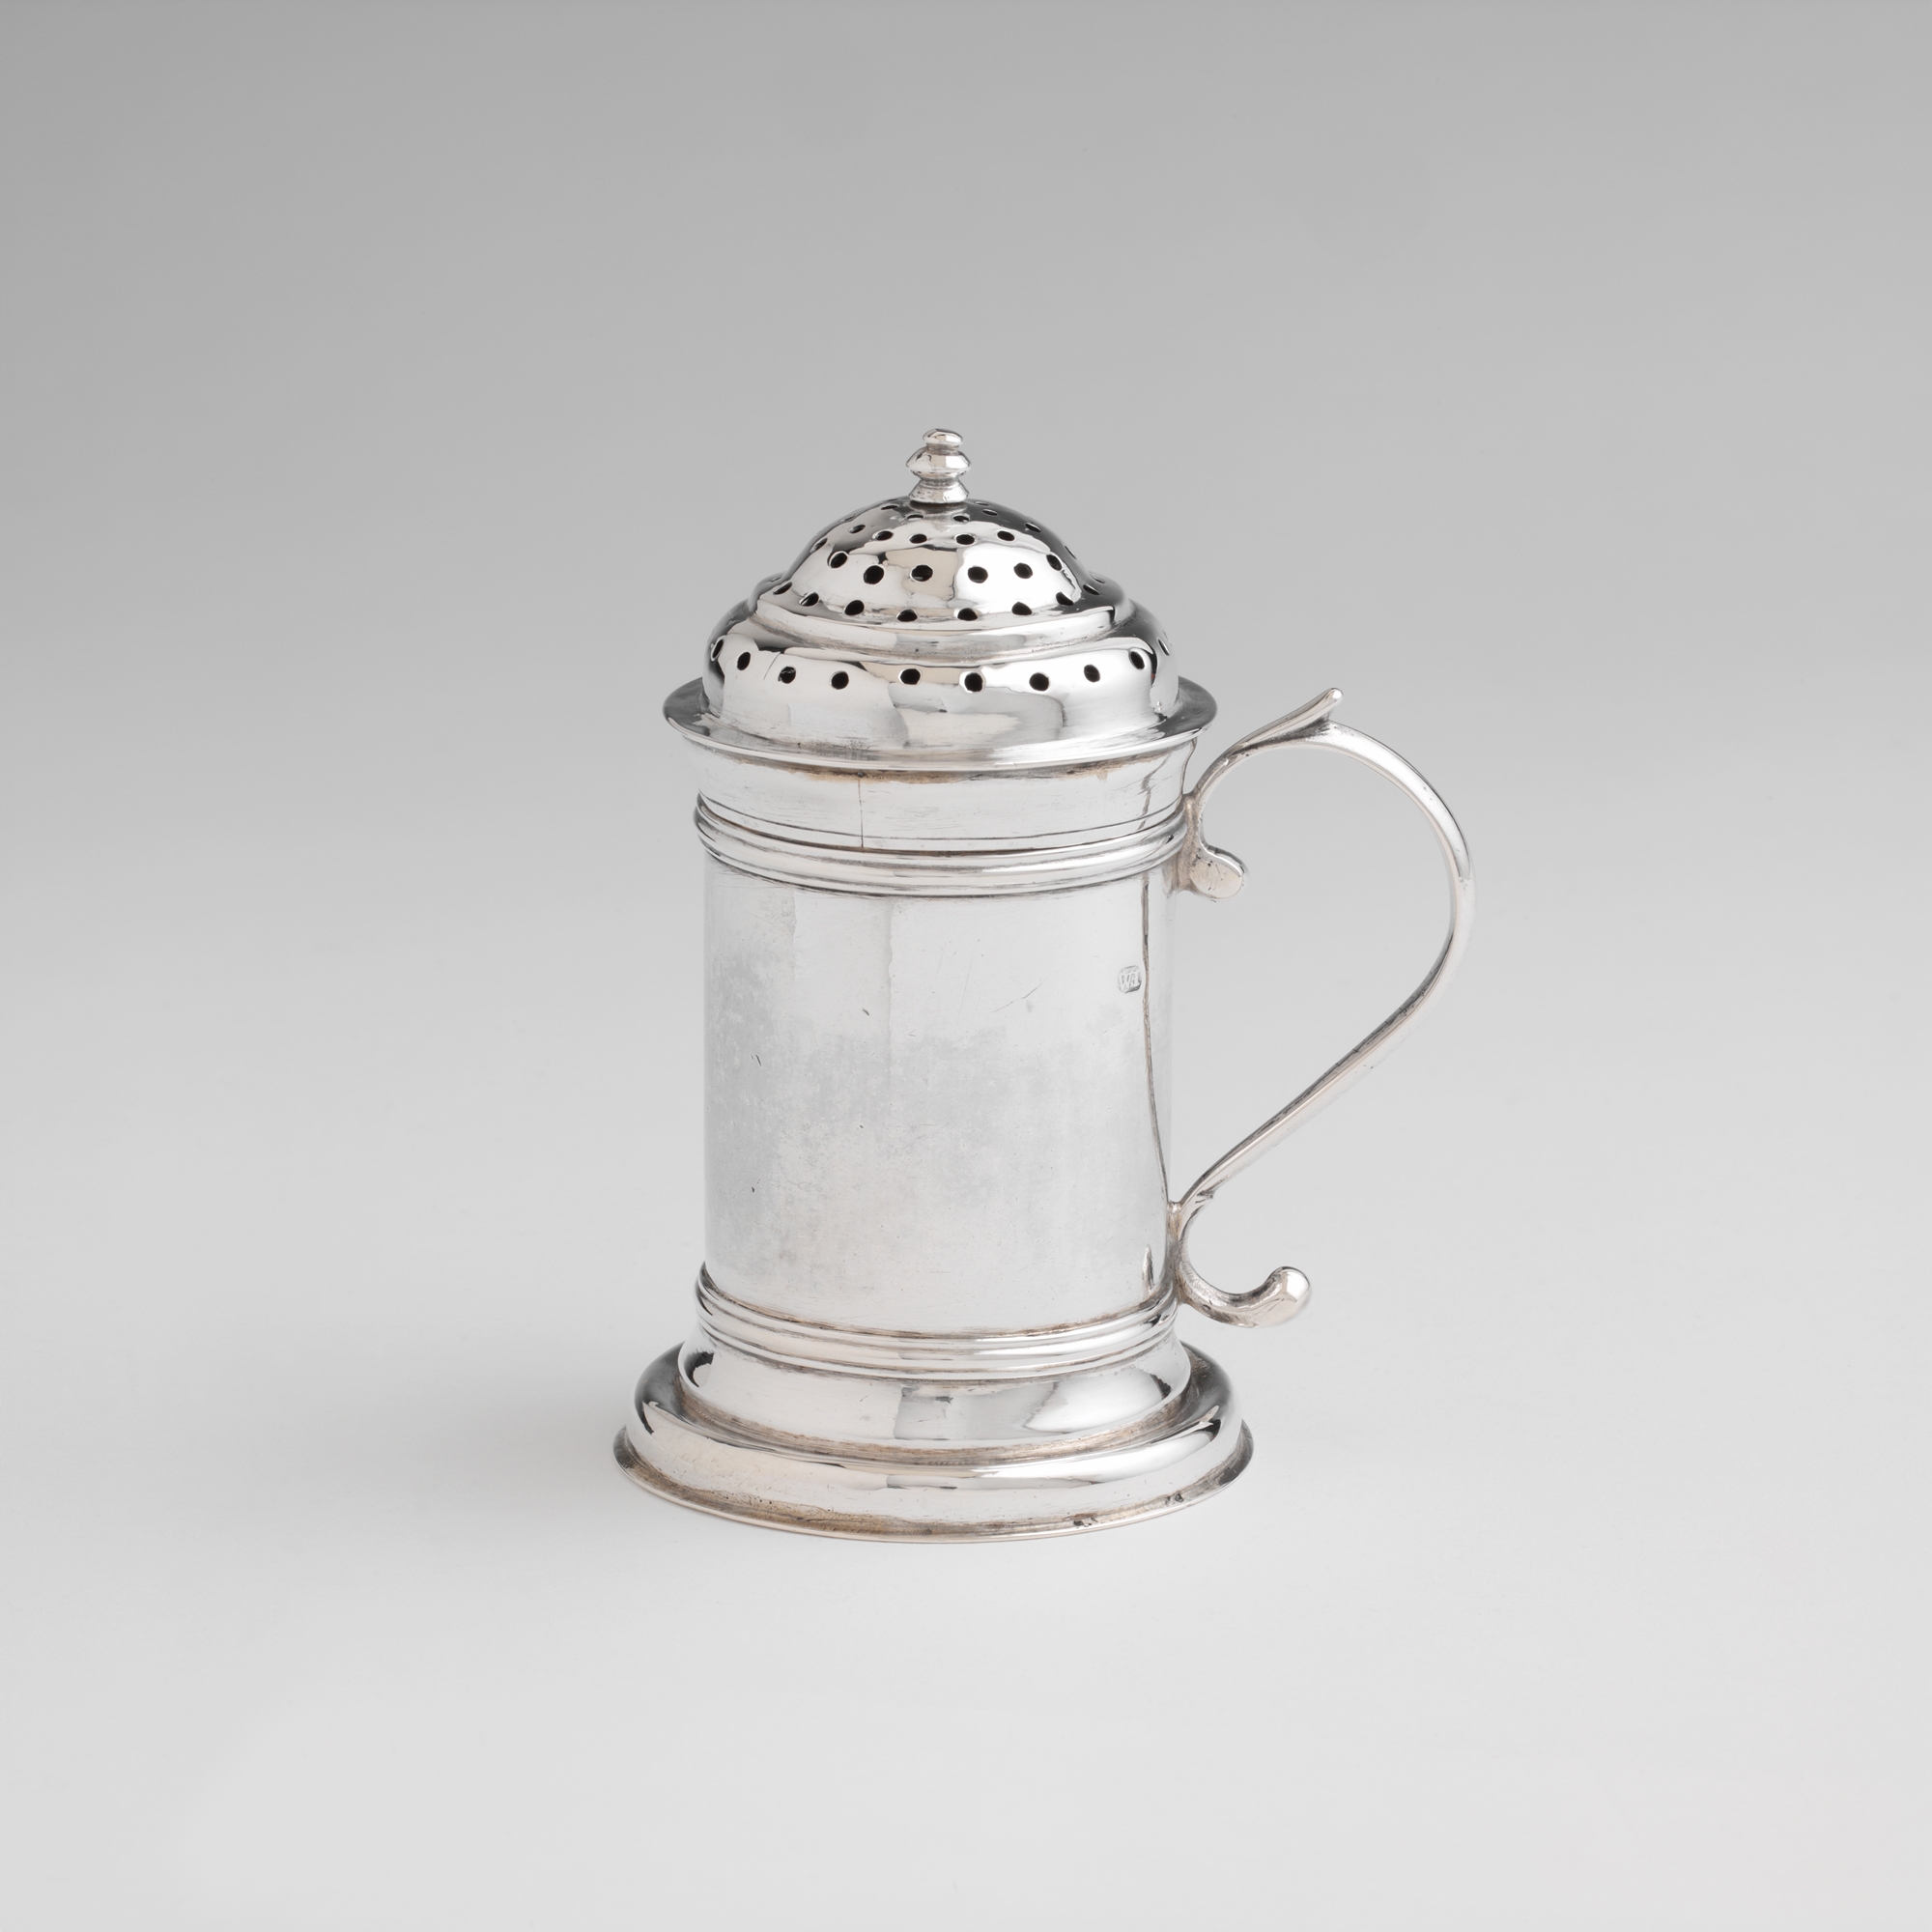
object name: caster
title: Pepper Caster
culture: american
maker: william jones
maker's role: maker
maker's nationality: american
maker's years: 1694-1730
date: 1720-1730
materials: silver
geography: united states